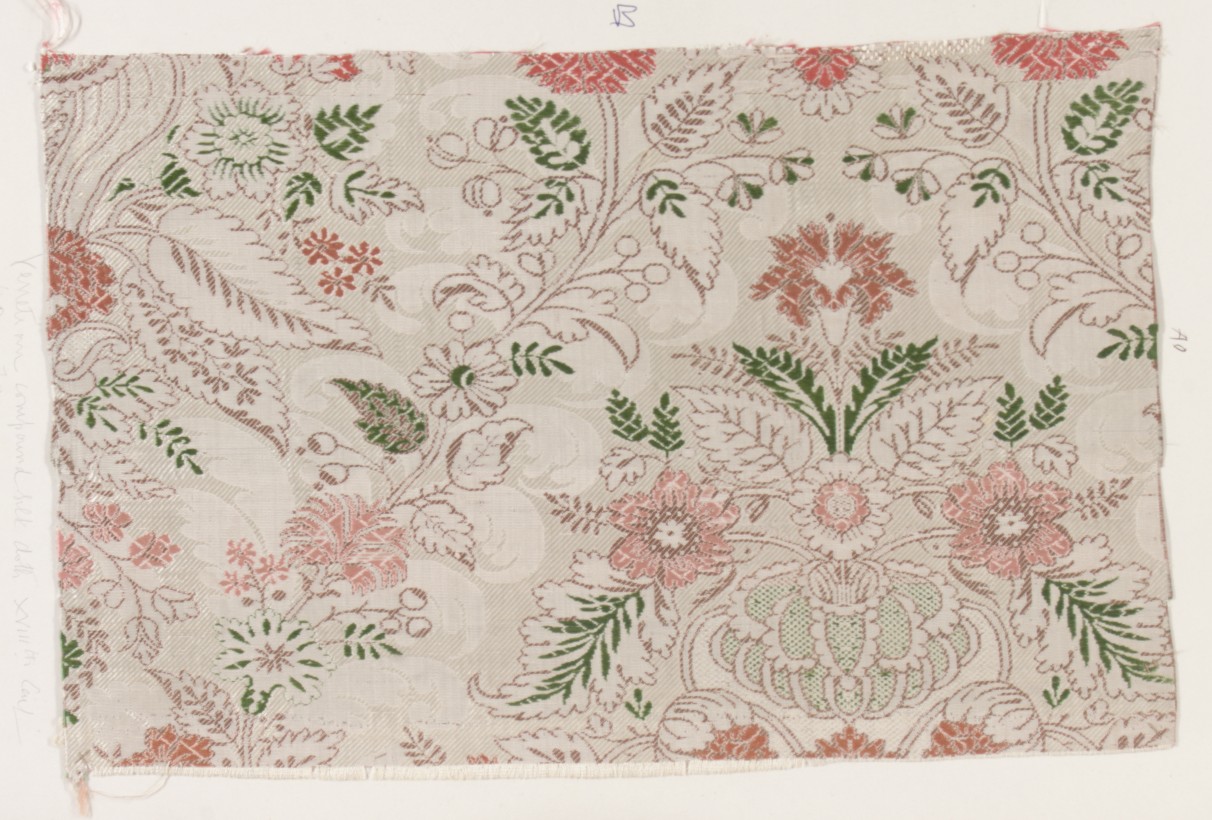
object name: fragment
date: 1701-1750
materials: silk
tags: flowers,leaves